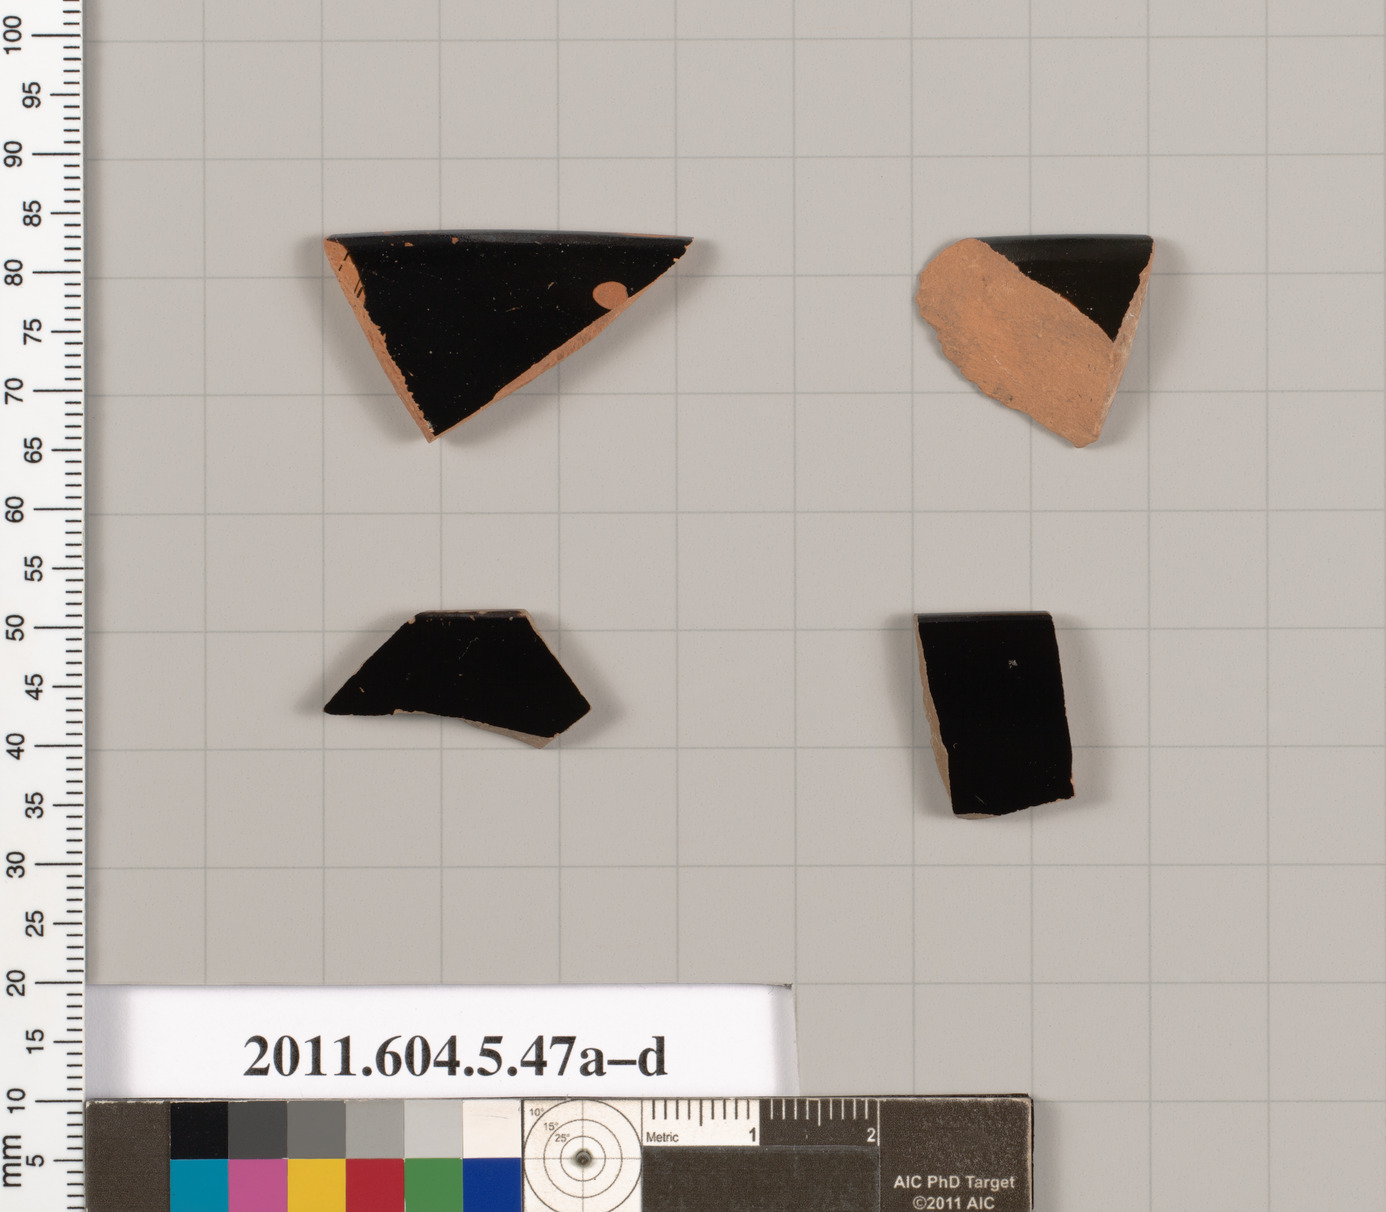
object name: kylix fragment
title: Terracotta rim fragments of kylikes (drinking cups)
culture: greek, attic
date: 500-480 BCE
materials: terracotta